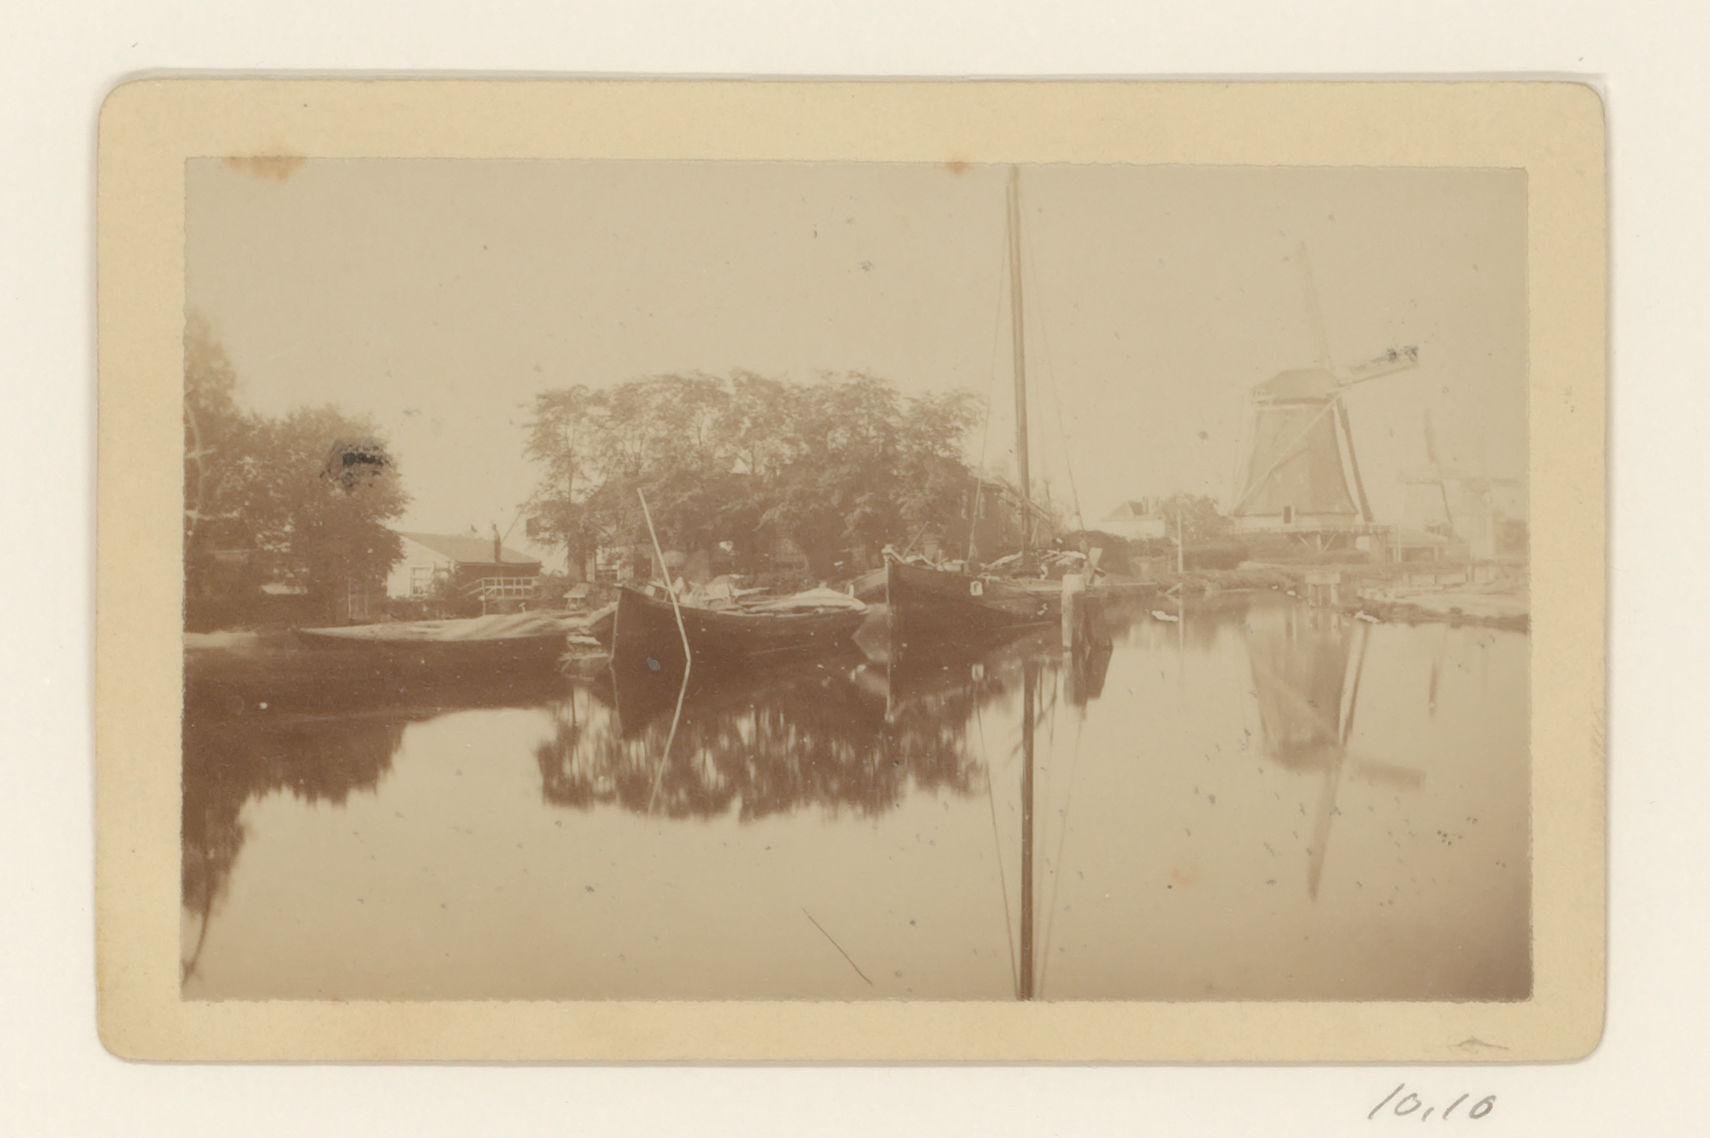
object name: cabinet photograph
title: Gezicht op het Mennonietenpad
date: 1850-1880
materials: cardboard, paper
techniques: albumen print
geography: amsterdam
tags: city-view in general; 'veduta', river, windmill in landscape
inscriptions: inscription: ‘12. Mennoniete Pad / Bokekhandel. - C.F. Stemler - Amsterdam.’, collector's mark: ‘10,10’ Lugt 1641b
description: Onderwerpsrubriek binnen de Atlas Amsterdam: Maagdelievenstraat, Markenplein, Marnixstraat, Martelaarsgracht, Meeuwenlaan, Mennonietenpad, Meijerplein (Jonas Daniël), Mozes en Aäronstraat, Muidergracht, Muntplein.